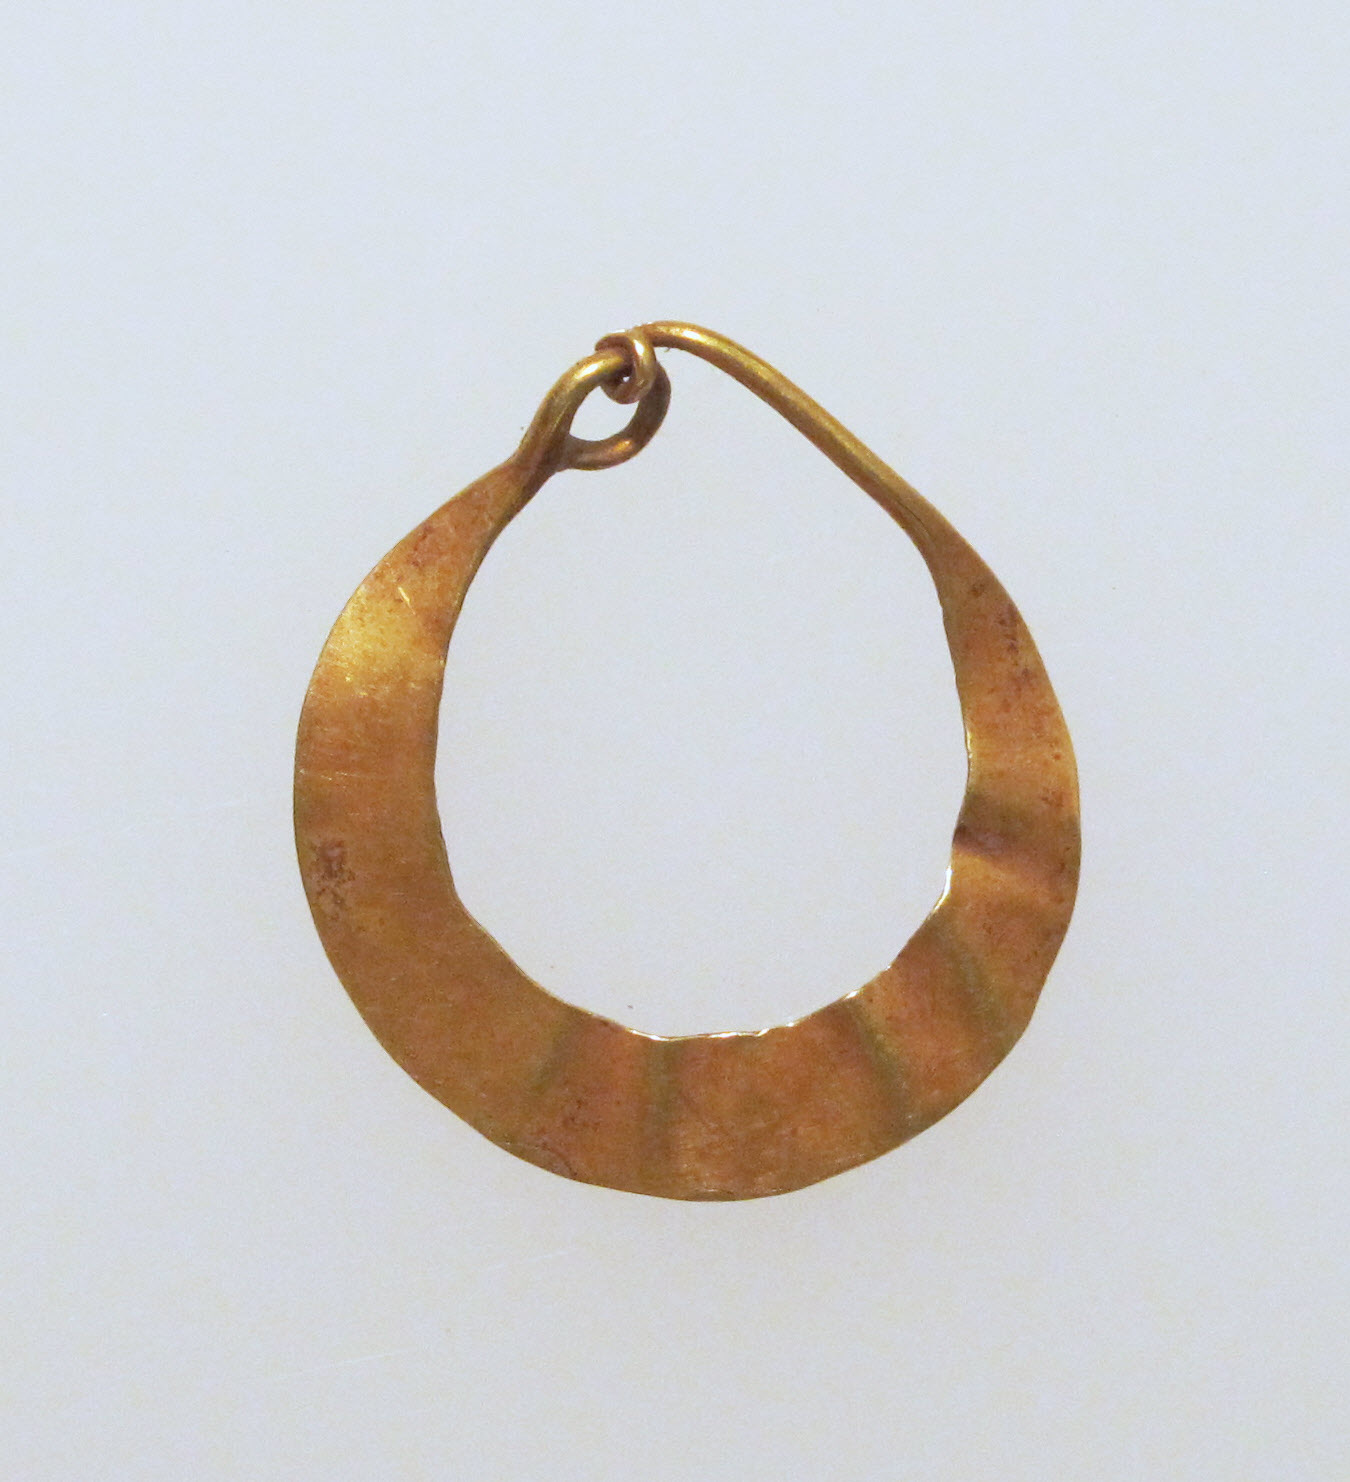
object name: earring, crescent shaped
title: Earring, crescent-shaped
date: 7000 BCE-330 CE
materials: gold